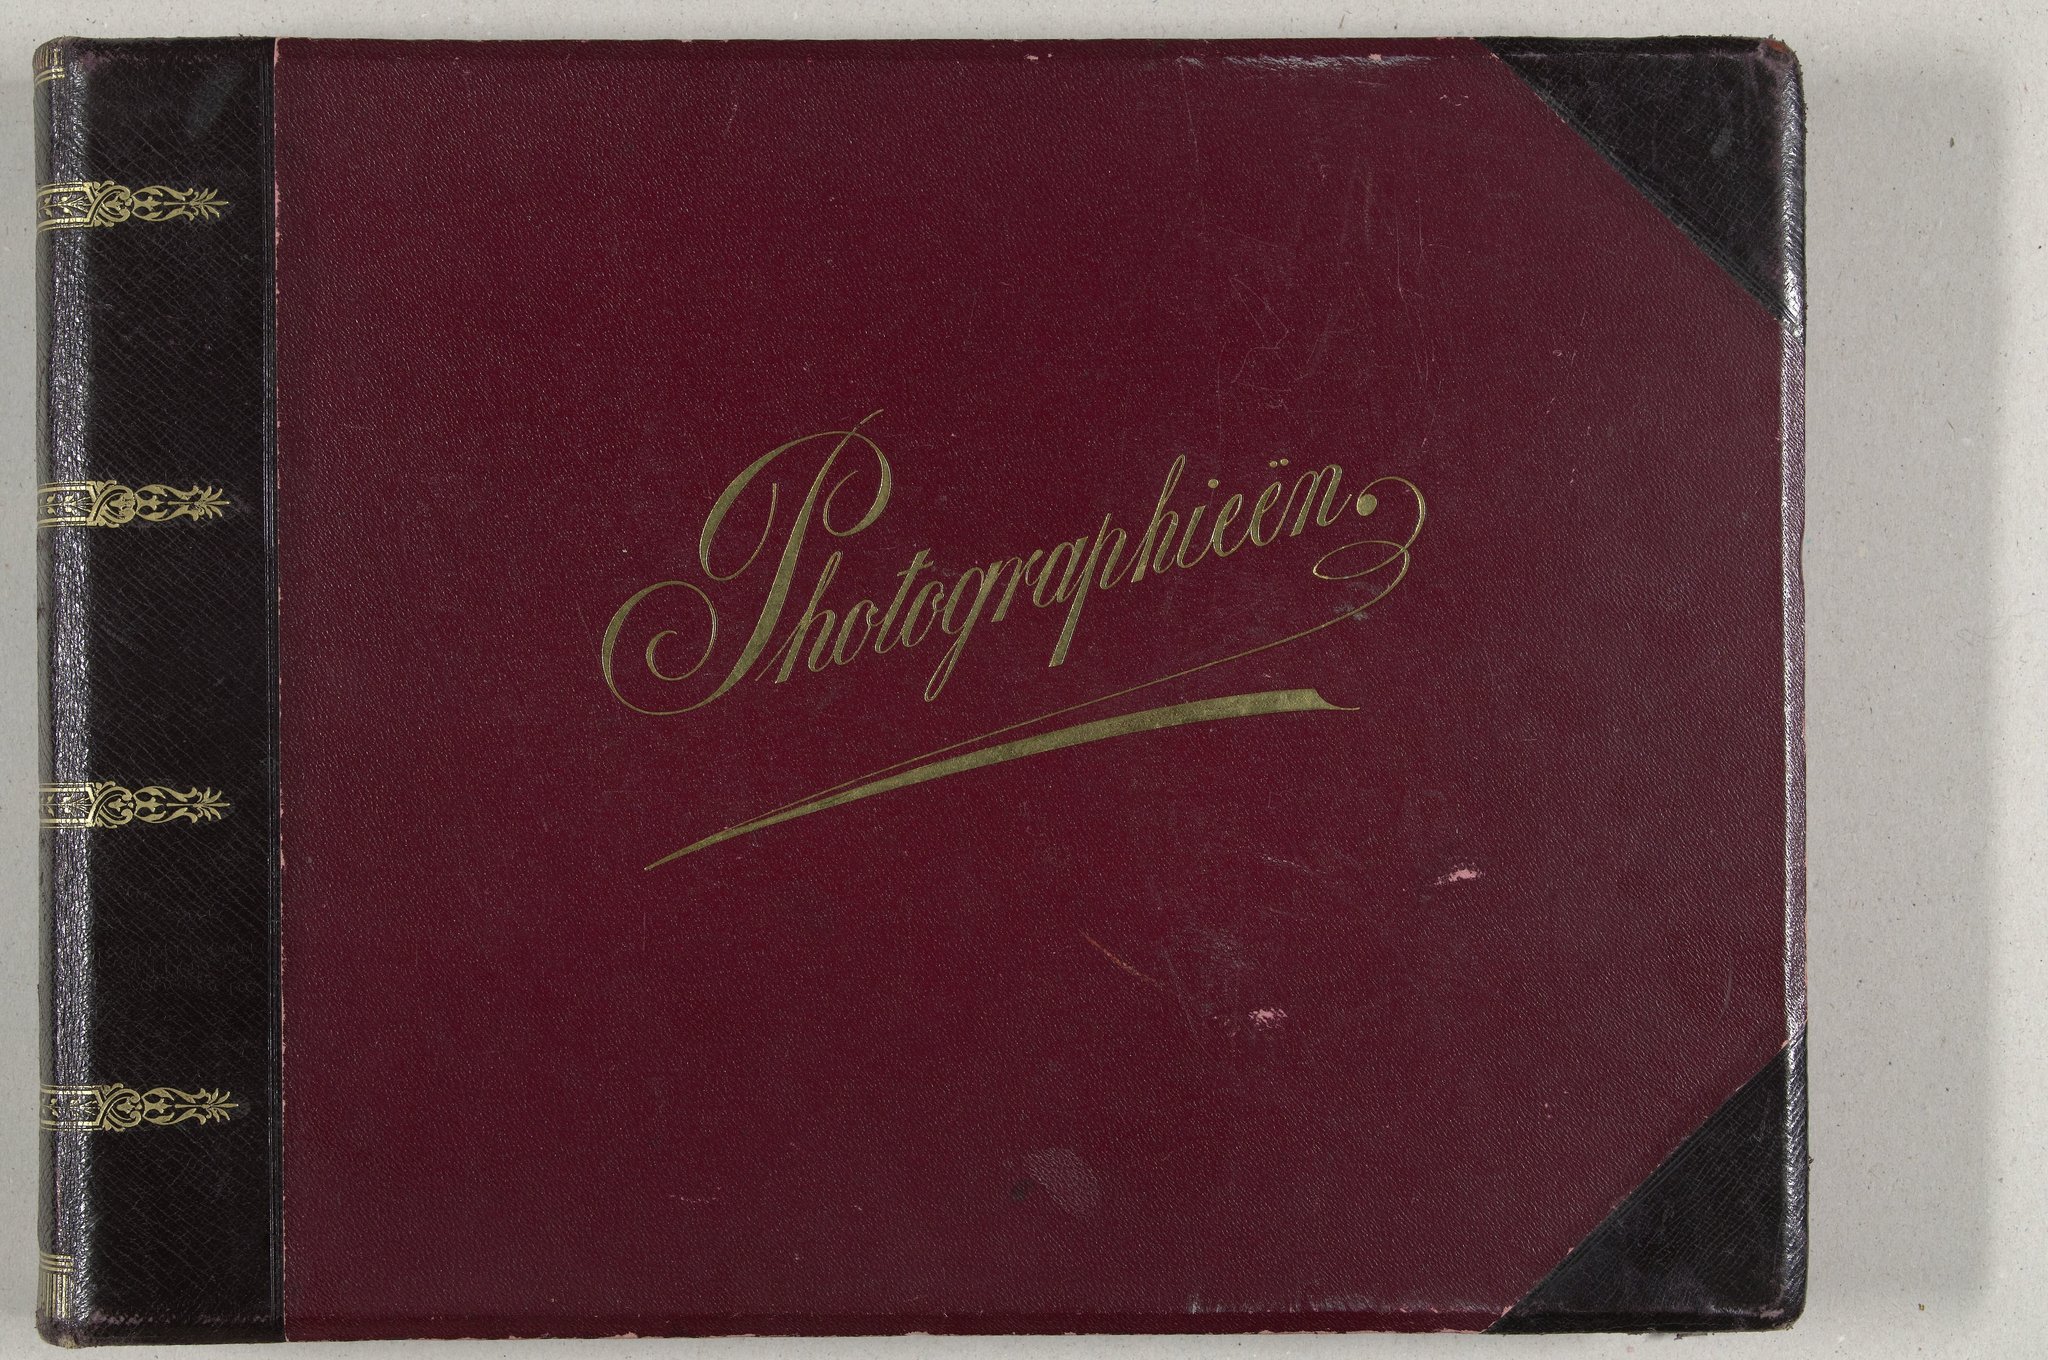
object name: scrapbook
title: Album Photographieën the Netherlands / Dutch East Indies (now Indonesia)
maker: frits freerks fontein fz.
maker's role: fotograaf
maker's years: 1882-1928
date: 1898-1915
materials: paper, cardboard, ink, leather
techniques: cyanotype, pen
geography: netherlands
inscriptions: stamp: ‘E. Fontein Pz[?]’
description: There are a substantial number of albums in the Netherlands of entrepreneurs, administrators, military men, and engineers who were stationed for some time in the Dutch East Indies. Fontein was a chemical engineer at the Bataafsche Petroleum Maatschappij (Batavian Oil Company) and sailed from Harlingen to Pekalongan. With over 160 photographs, this album bears witness to both his time in the Netherlands and years in the tropics.